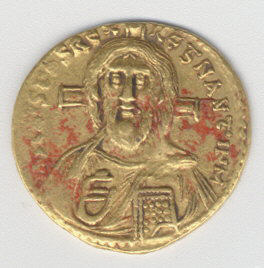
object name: solidus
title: Solidus of Justinian II (685-95)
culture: byzantine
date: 692-695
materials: gold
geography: constantinople